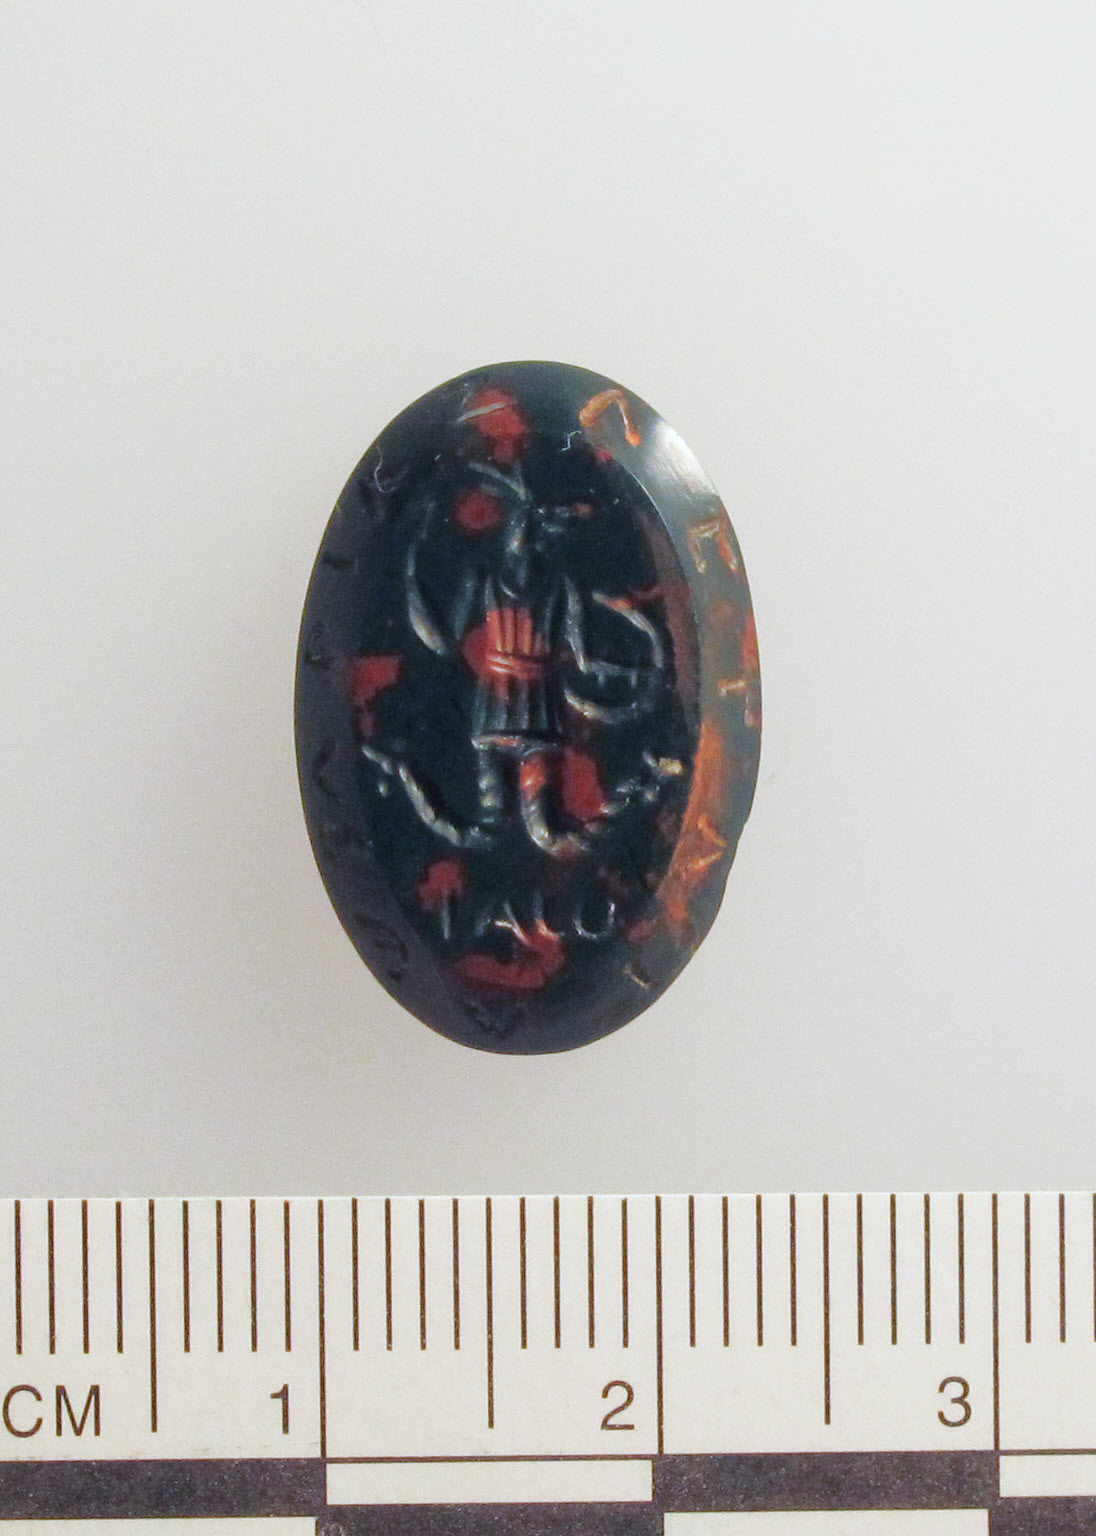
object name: intaglio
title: Heliotrope intaglio: Cock-headed anguipes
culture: roman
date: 201-300